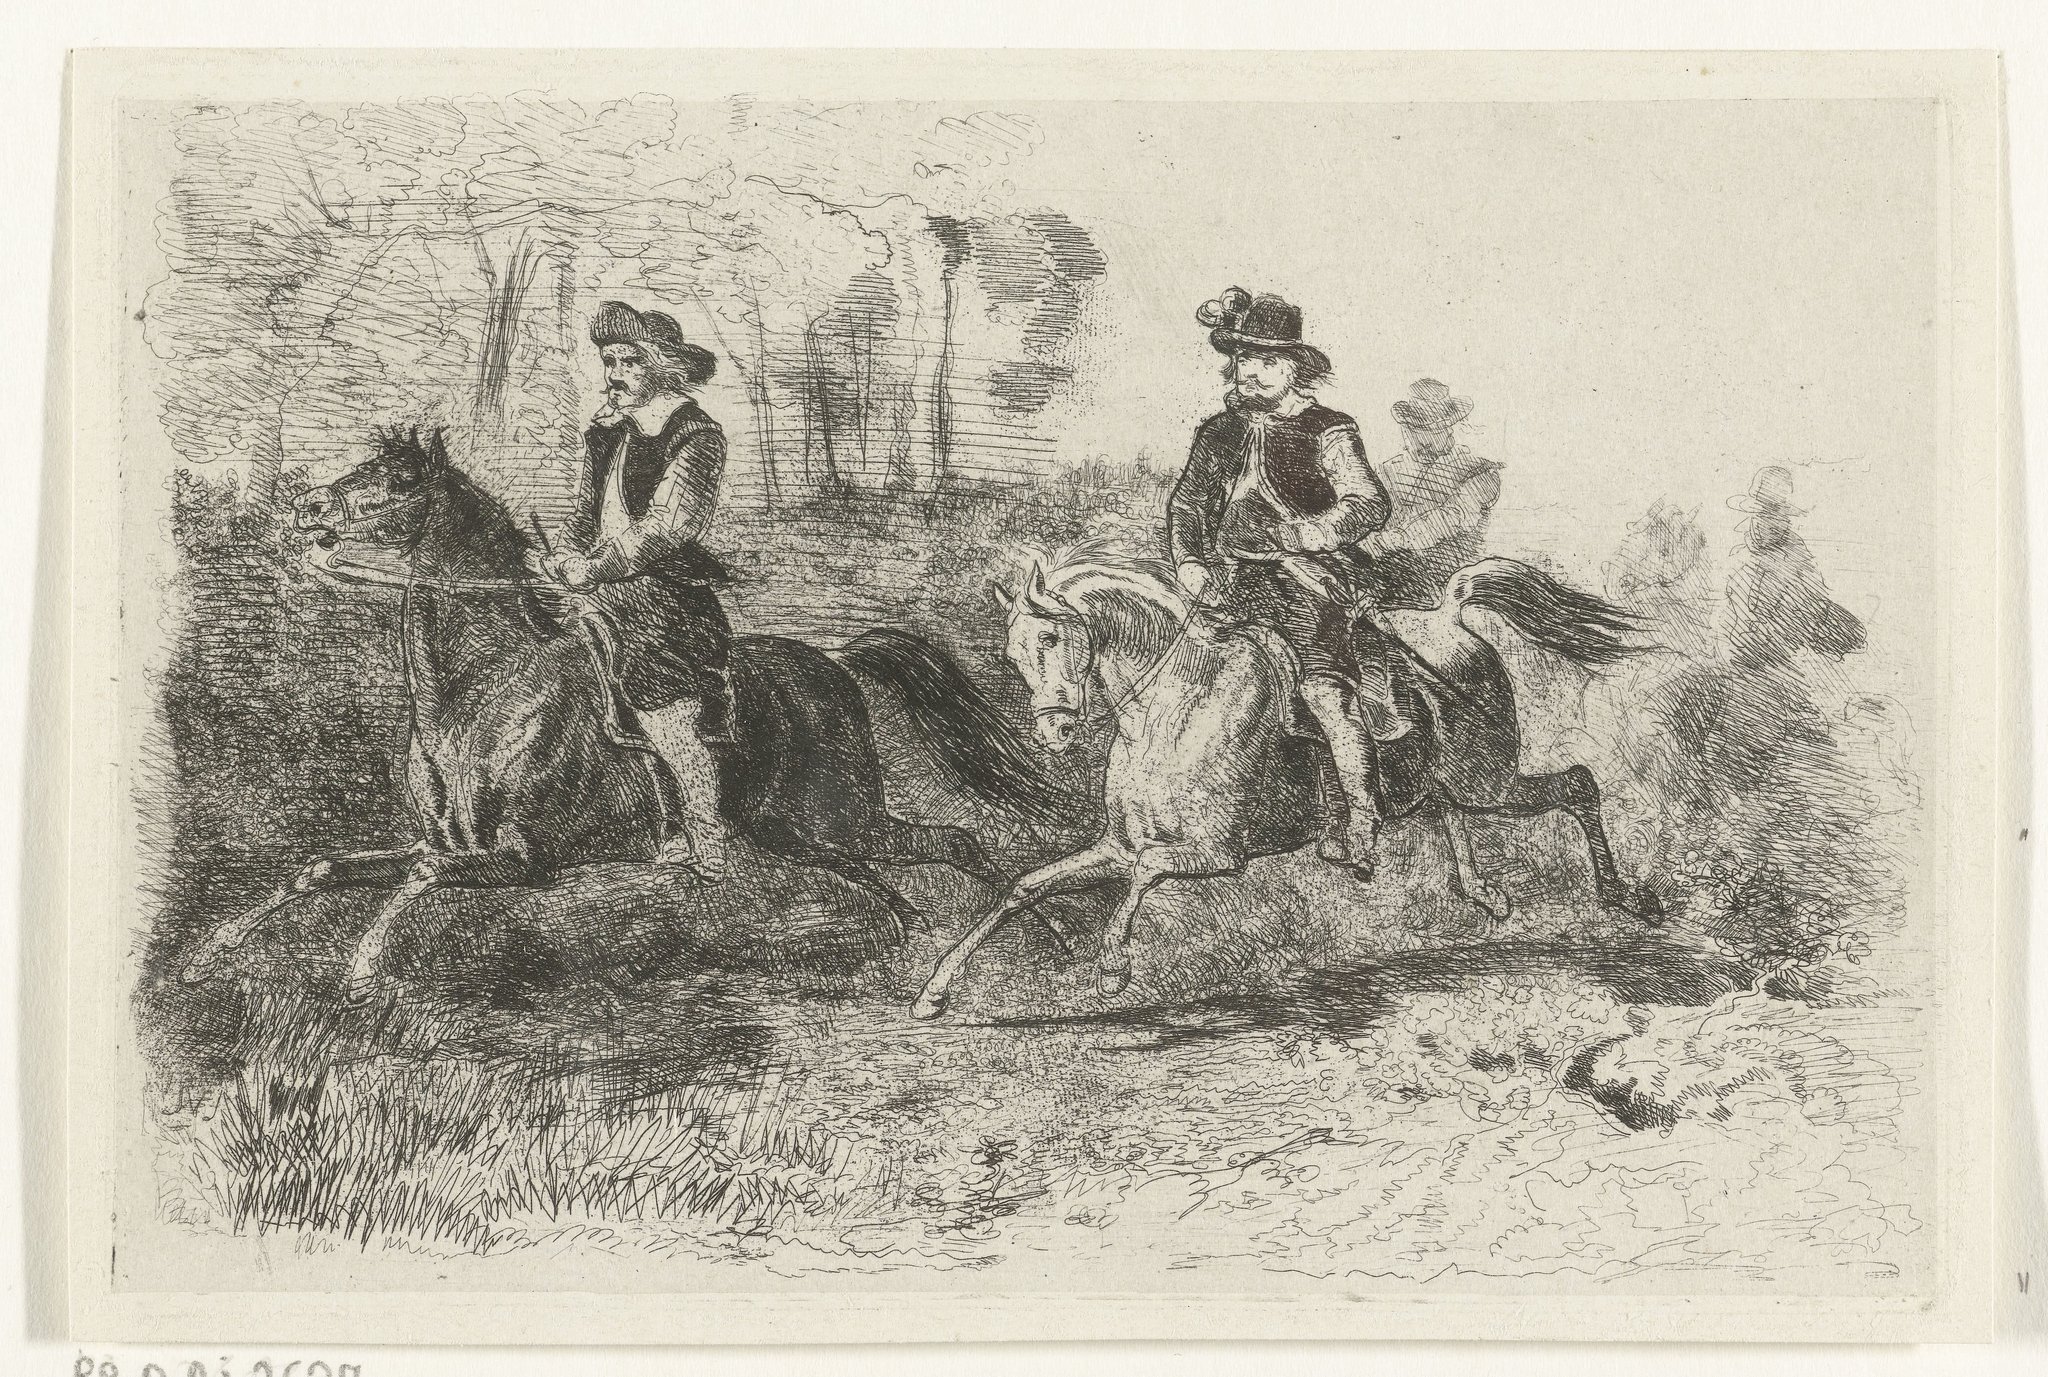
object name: print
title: Ruiters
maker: karel frederik bombled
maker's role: draughtsman, print maker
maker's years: 1822-1902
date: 1832-1902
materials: paper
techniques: etching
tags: riding a horse, ass, or mule; rider, horseman, forest path or lane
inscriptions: collector's mark: Lugt 2228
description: niet genoemd in literatuur. 2 staten aanwezig in het RMA